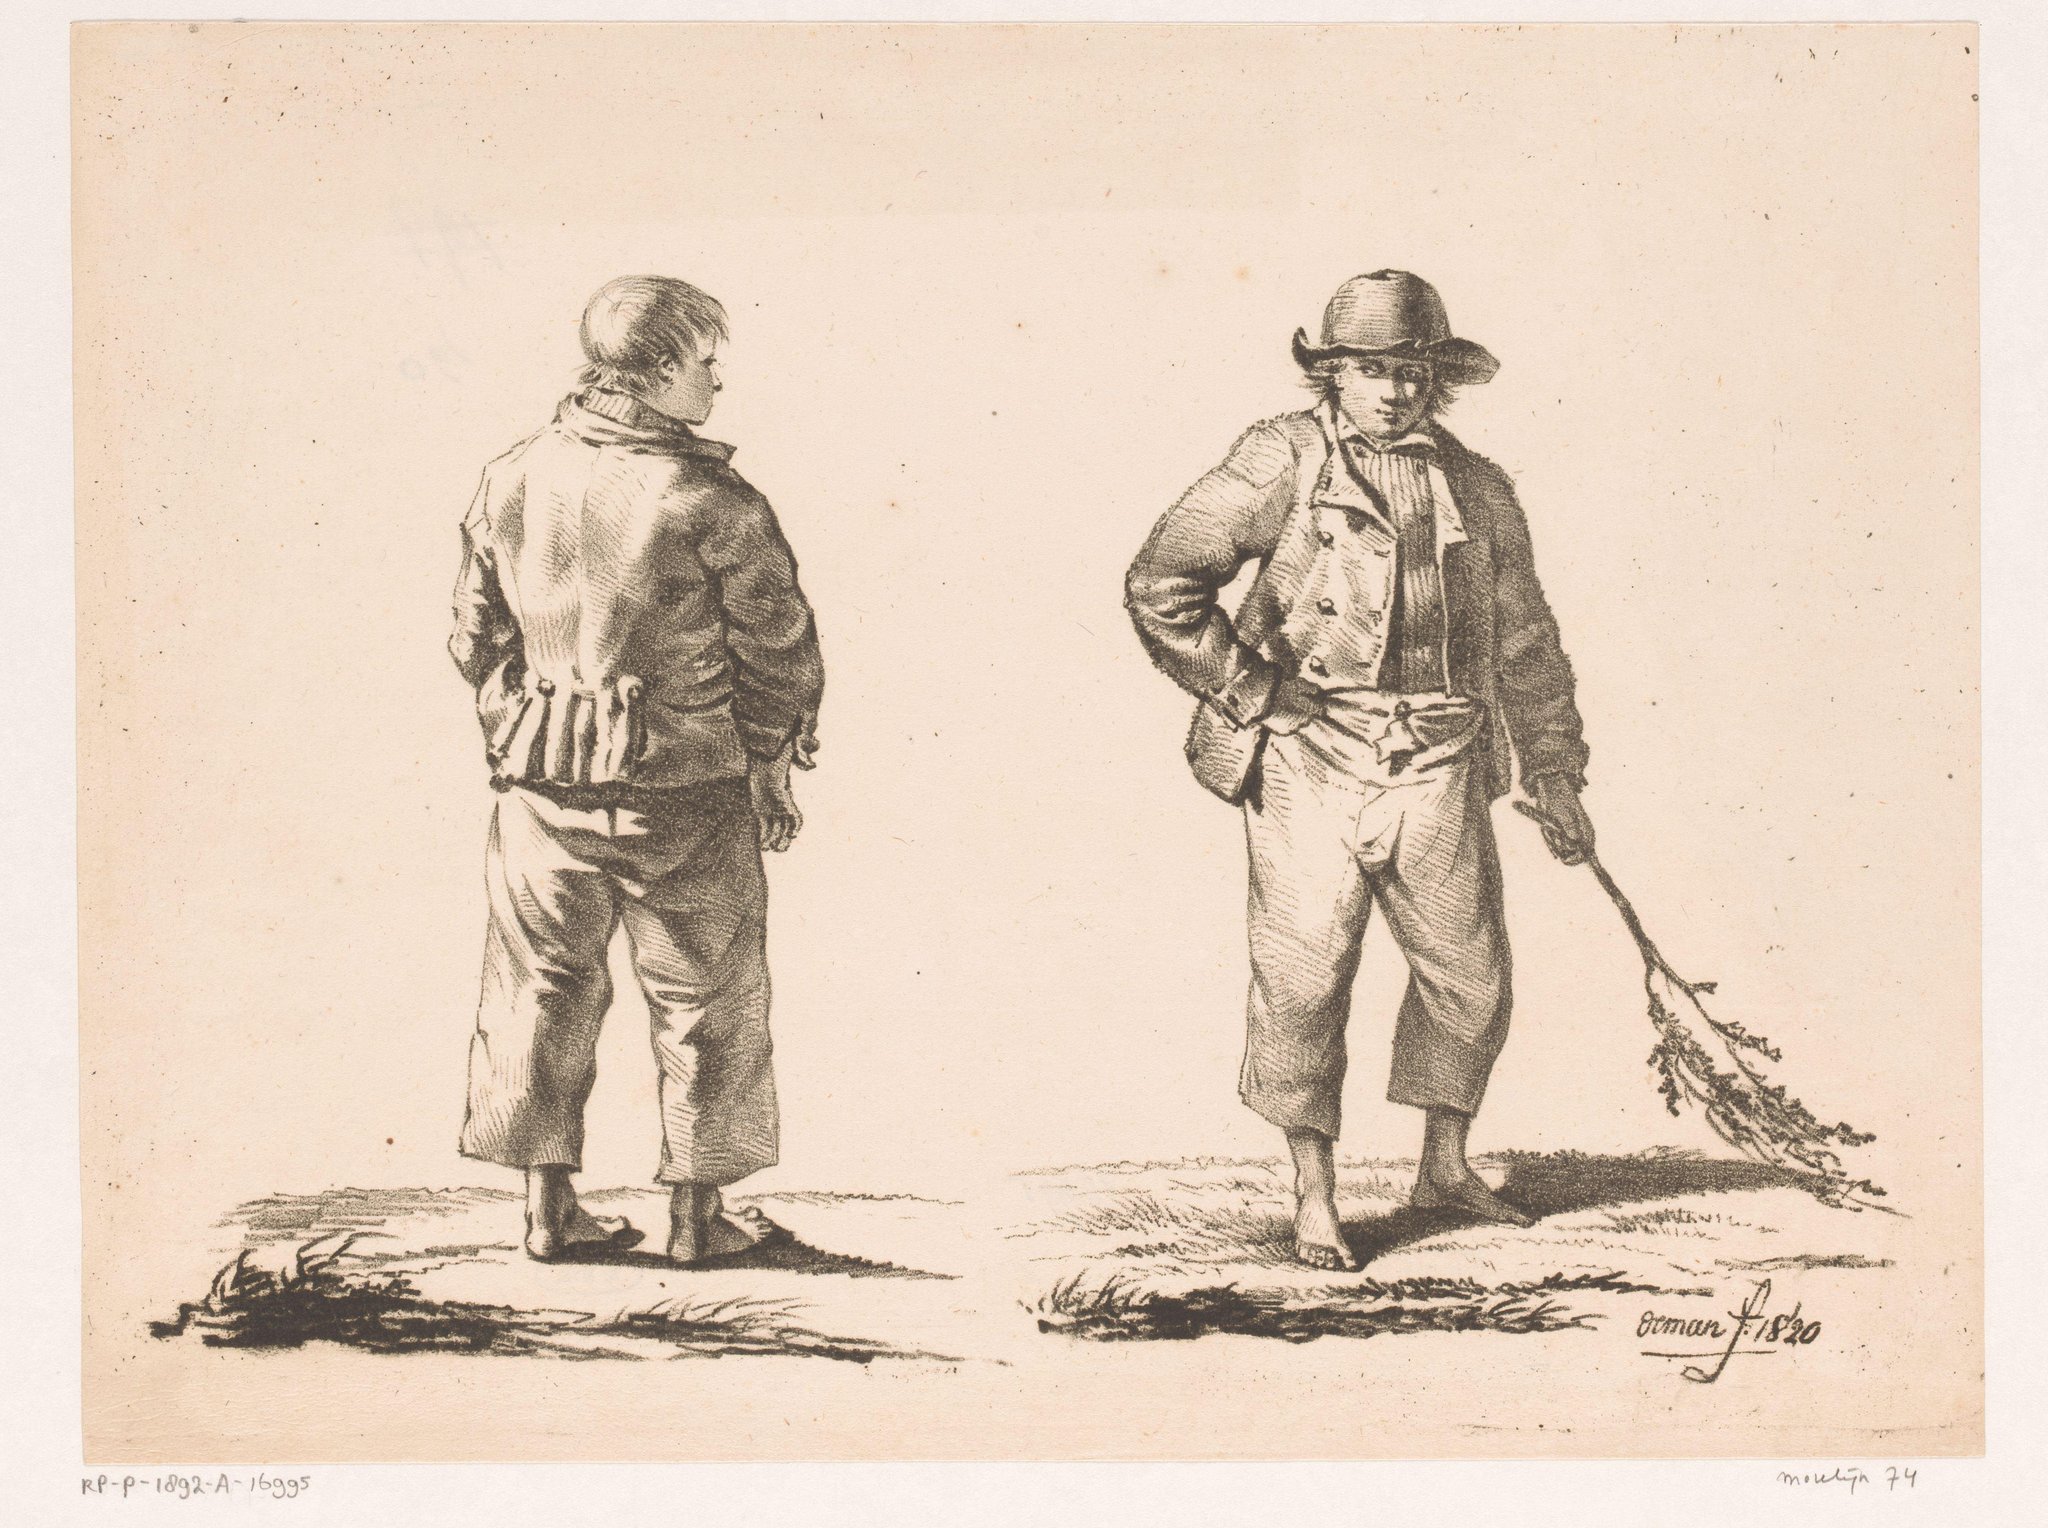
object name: print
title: Twee boeren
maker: anthonie willem hendrik nolthenius de man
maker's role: draughtsman, print maker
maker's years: 1793-1842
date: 1820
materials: paper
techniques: lithograph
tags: trees (+ branch, stick), farmers, barefoot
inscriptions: watermark: ‘K I K’, collector's mark: Lugt 2228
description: Een van de boeren is op de rug gezien. De tweede boer draagt een hoed en heeft een tak met bladeren in zijn linkerhand. Beiden hebben blote voeten.